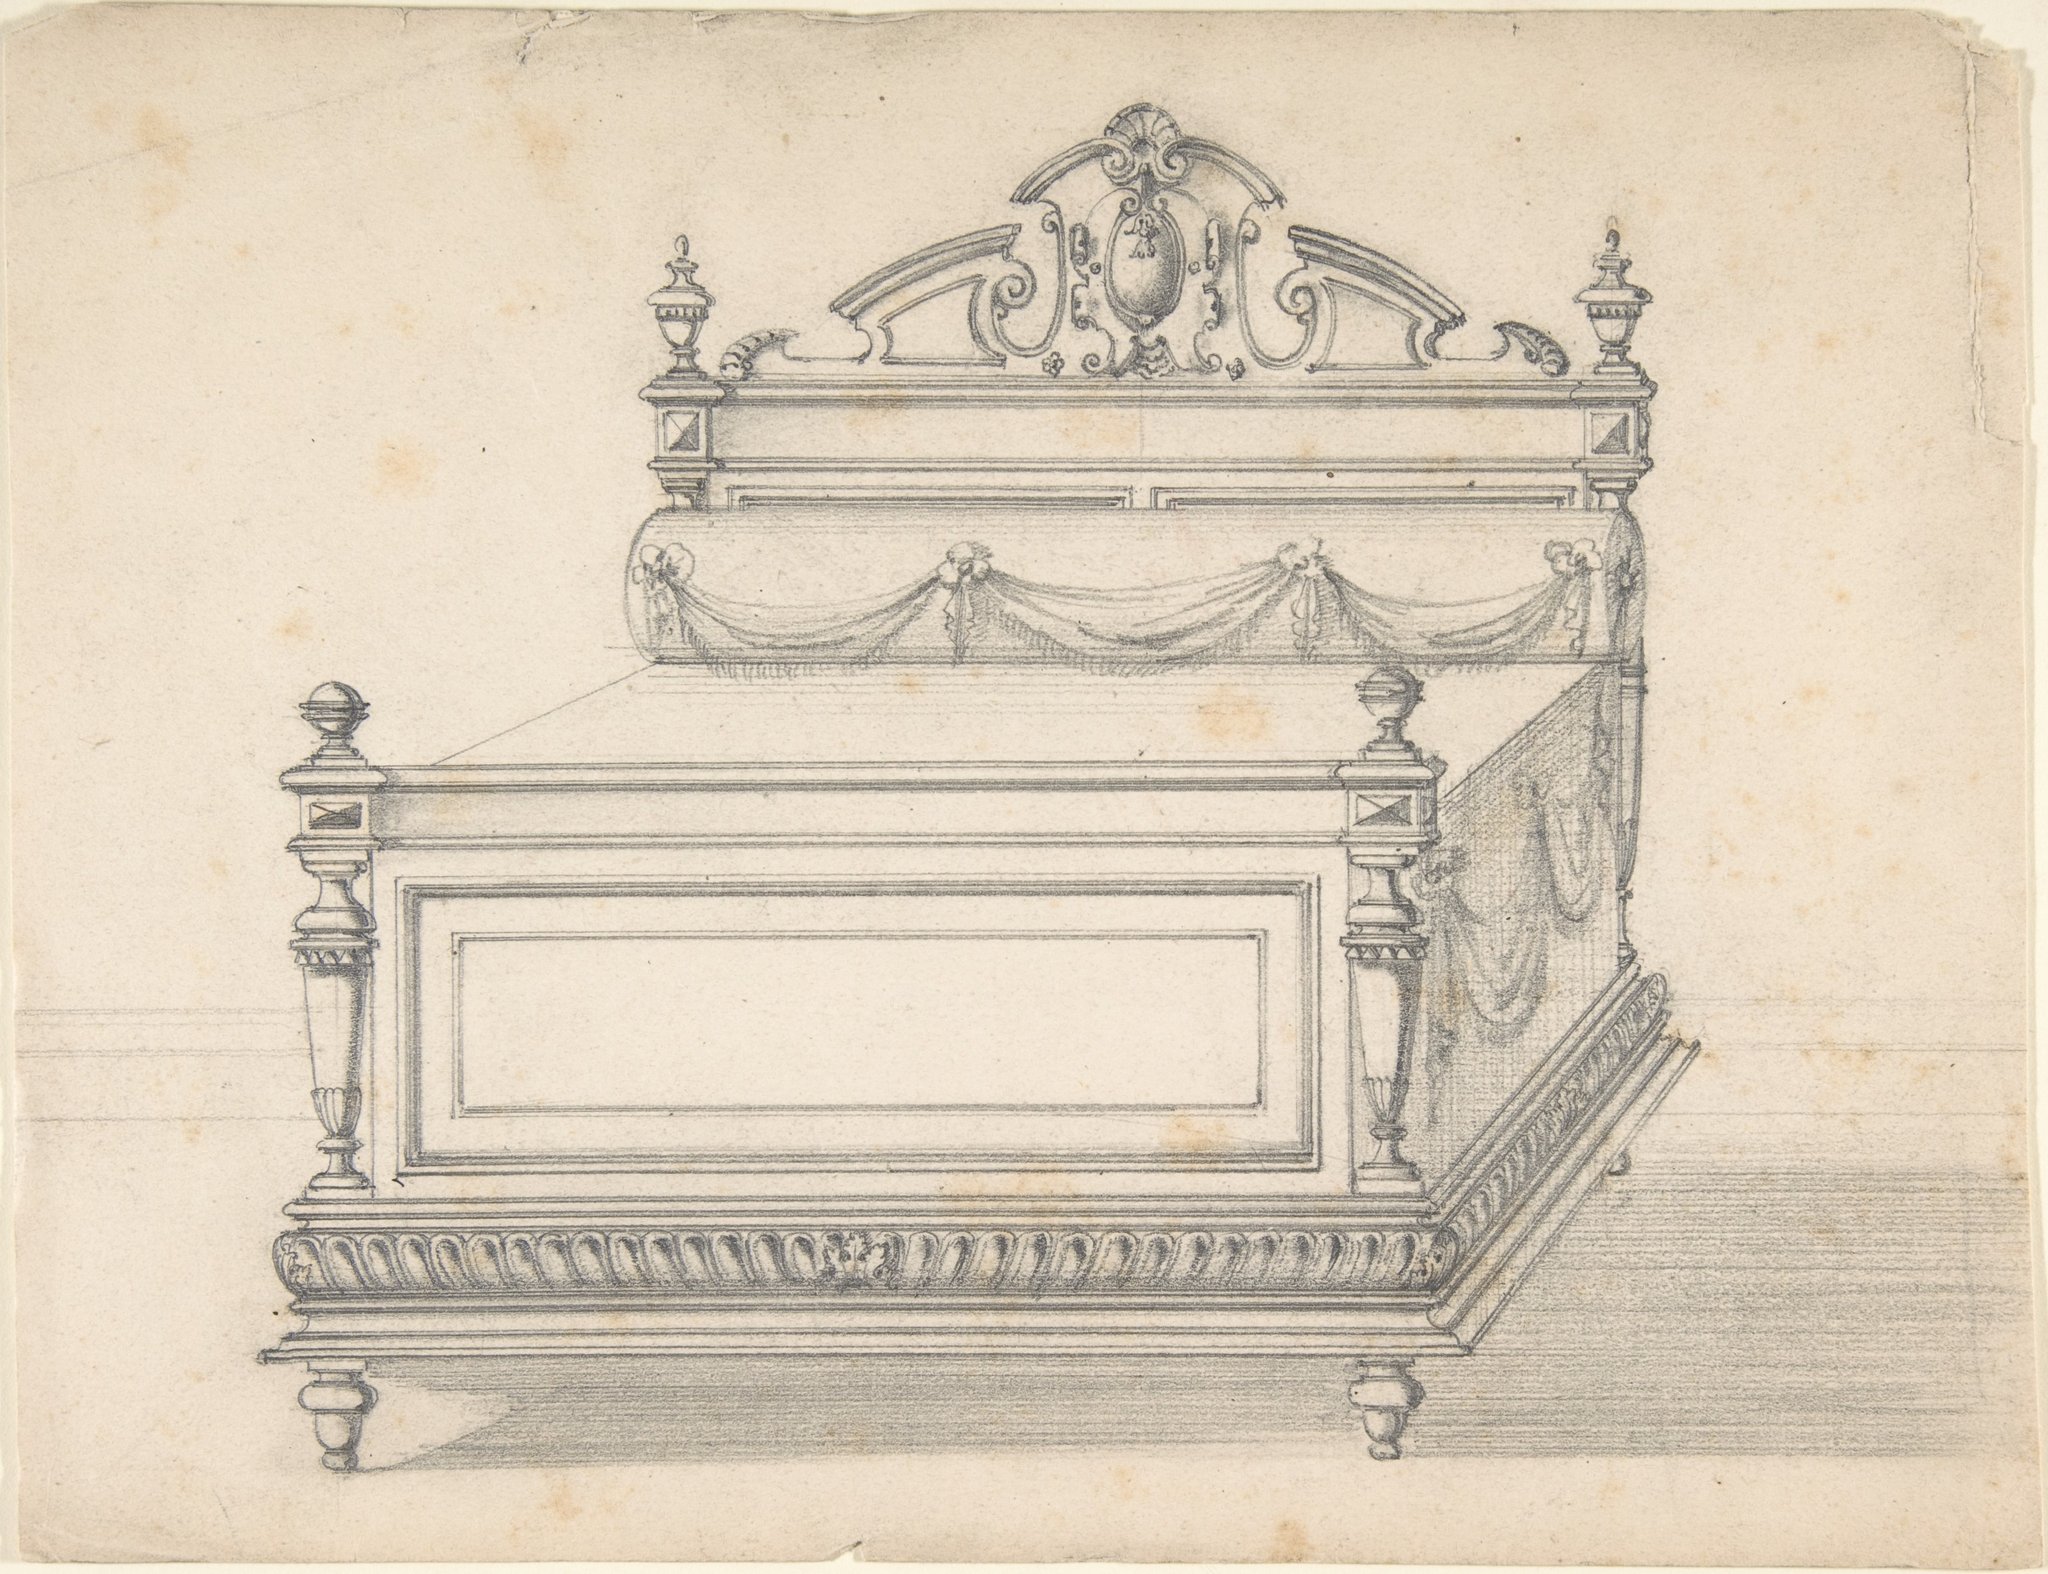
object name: drawing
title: Design for Bed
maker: anonymous, french, 19th century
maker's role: artist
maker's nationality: french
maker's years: 1800-1900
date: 1801-1900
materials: graphite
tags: beds